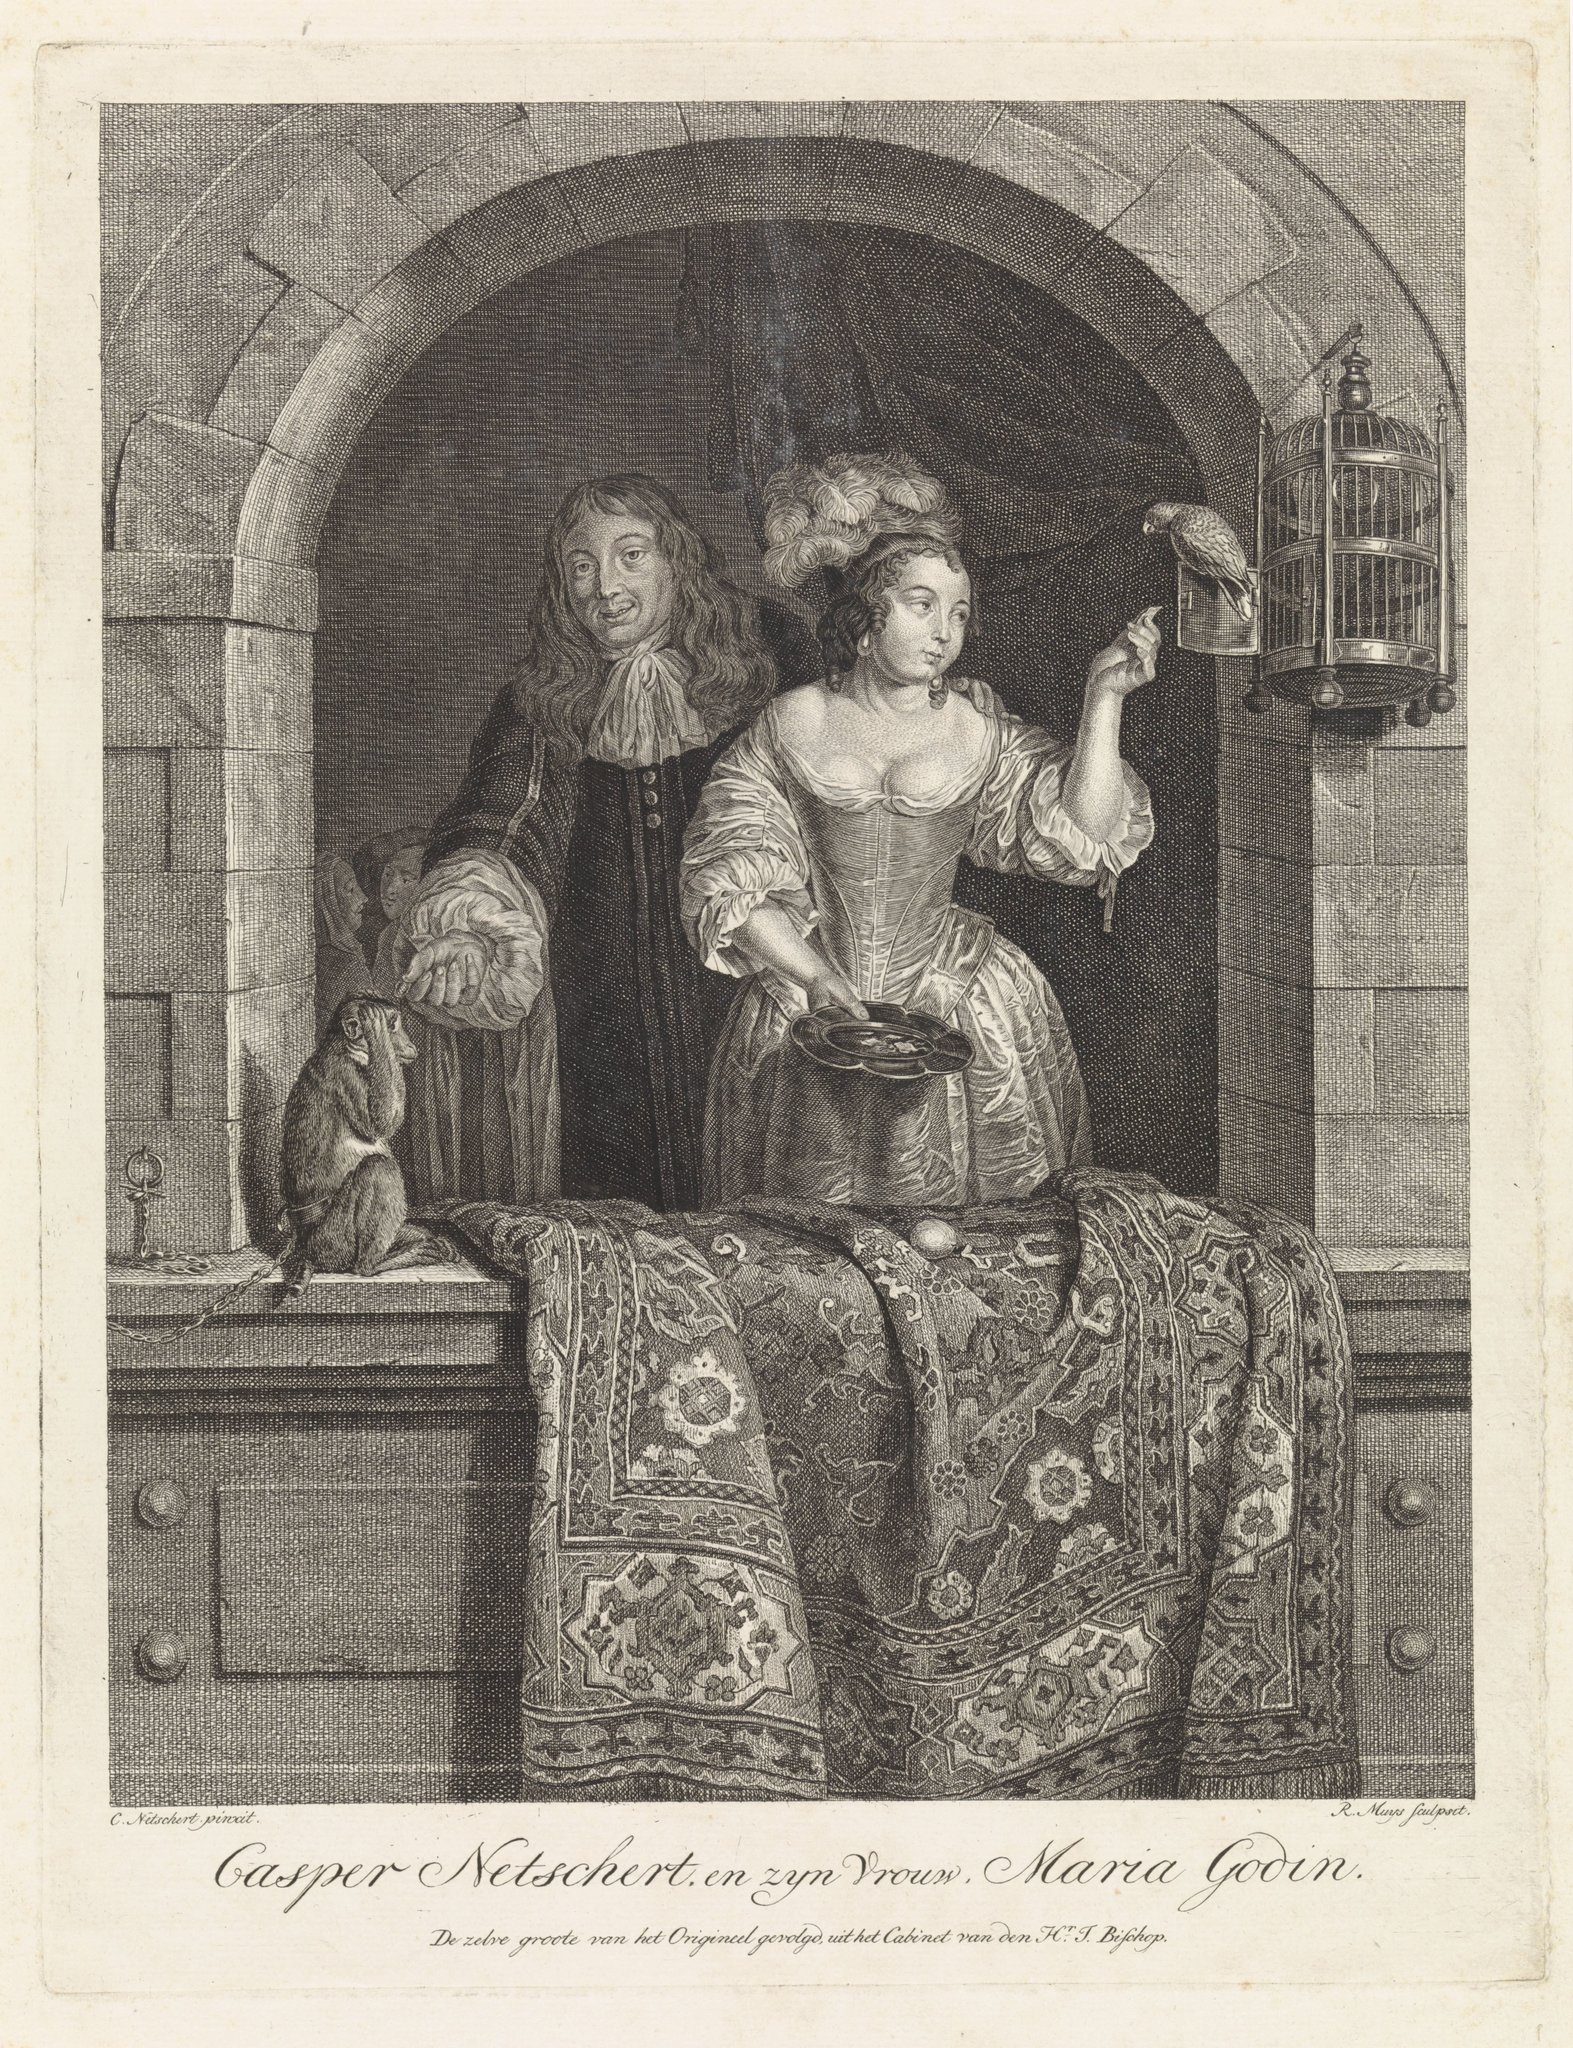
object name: print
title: Caspar Netscher en Margaretha Godin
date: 1752-1771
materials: paper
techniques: engraving, etching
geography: rotterdam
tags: monkeys, apes, ornamental birds: parrot, portrait, self-portrait of painter, couple of lovers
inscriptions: collector's mark: Lugt 2228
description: De schilder Caspar Netscher en zijn echtgenote Margaretha Godin staande in een boogvormig venster. Caspar Netscher voert een pinda aan een aapje op de vensterbank. Margaretha Godin voert een papegaai. Over de vensterbank hangt een tapijt. In de ruimte achter het echtpaar staan een man en vrouw.